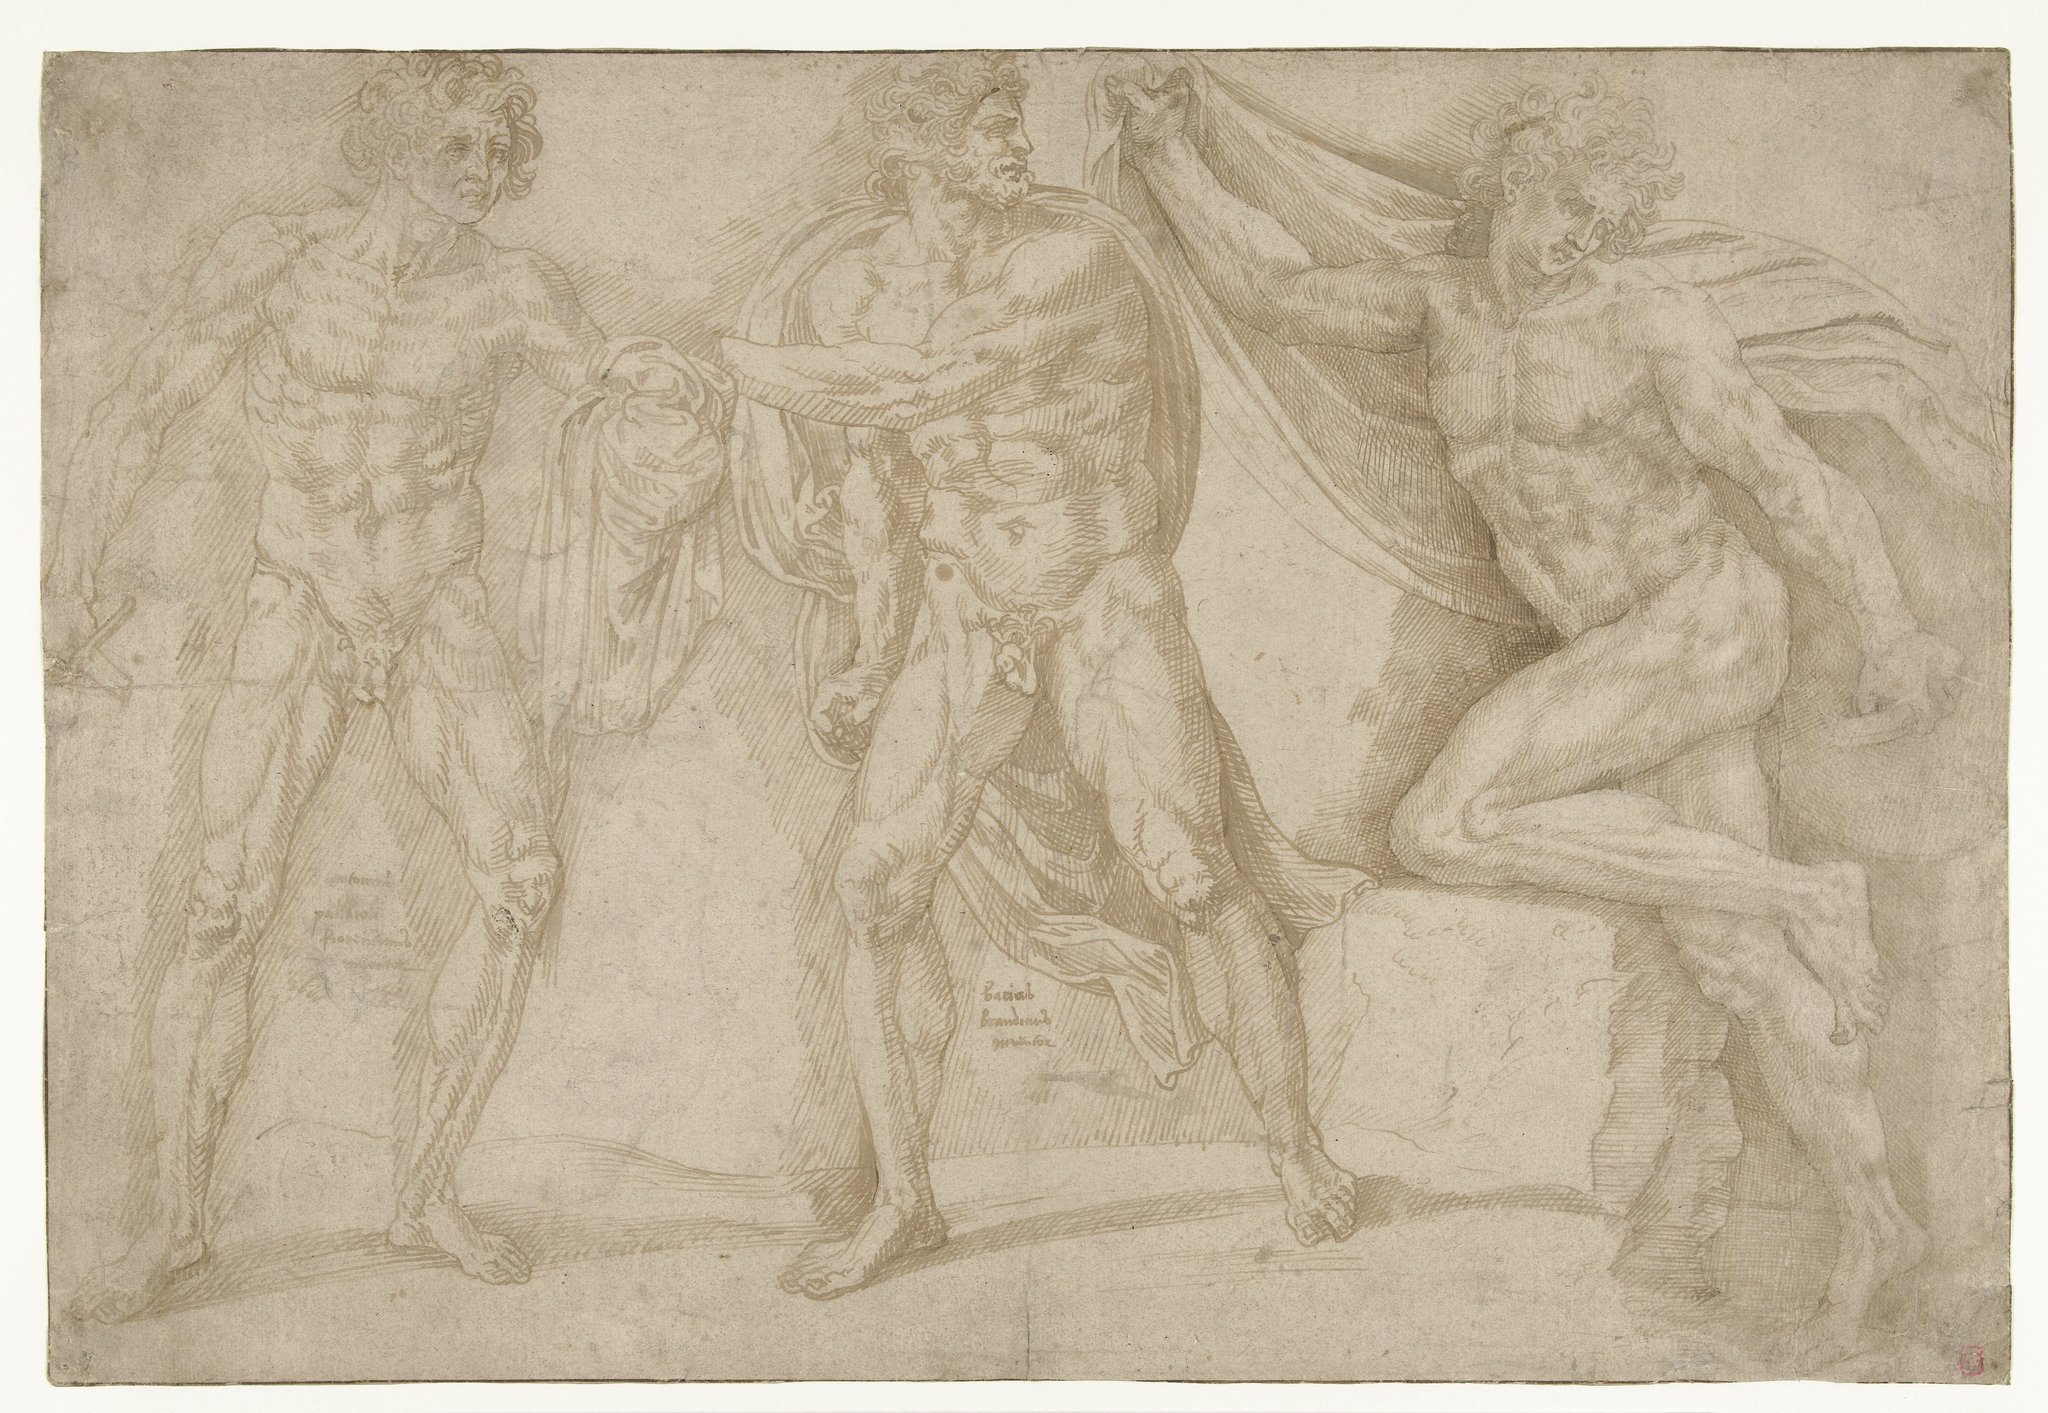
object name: drawing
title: Drie naakte mannen in verschillende houdingen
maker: lambert lombard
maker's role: draughtsman, print maker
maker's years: 1505-1566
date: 1537-1539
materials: ink, paper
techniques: pen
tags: standing figure